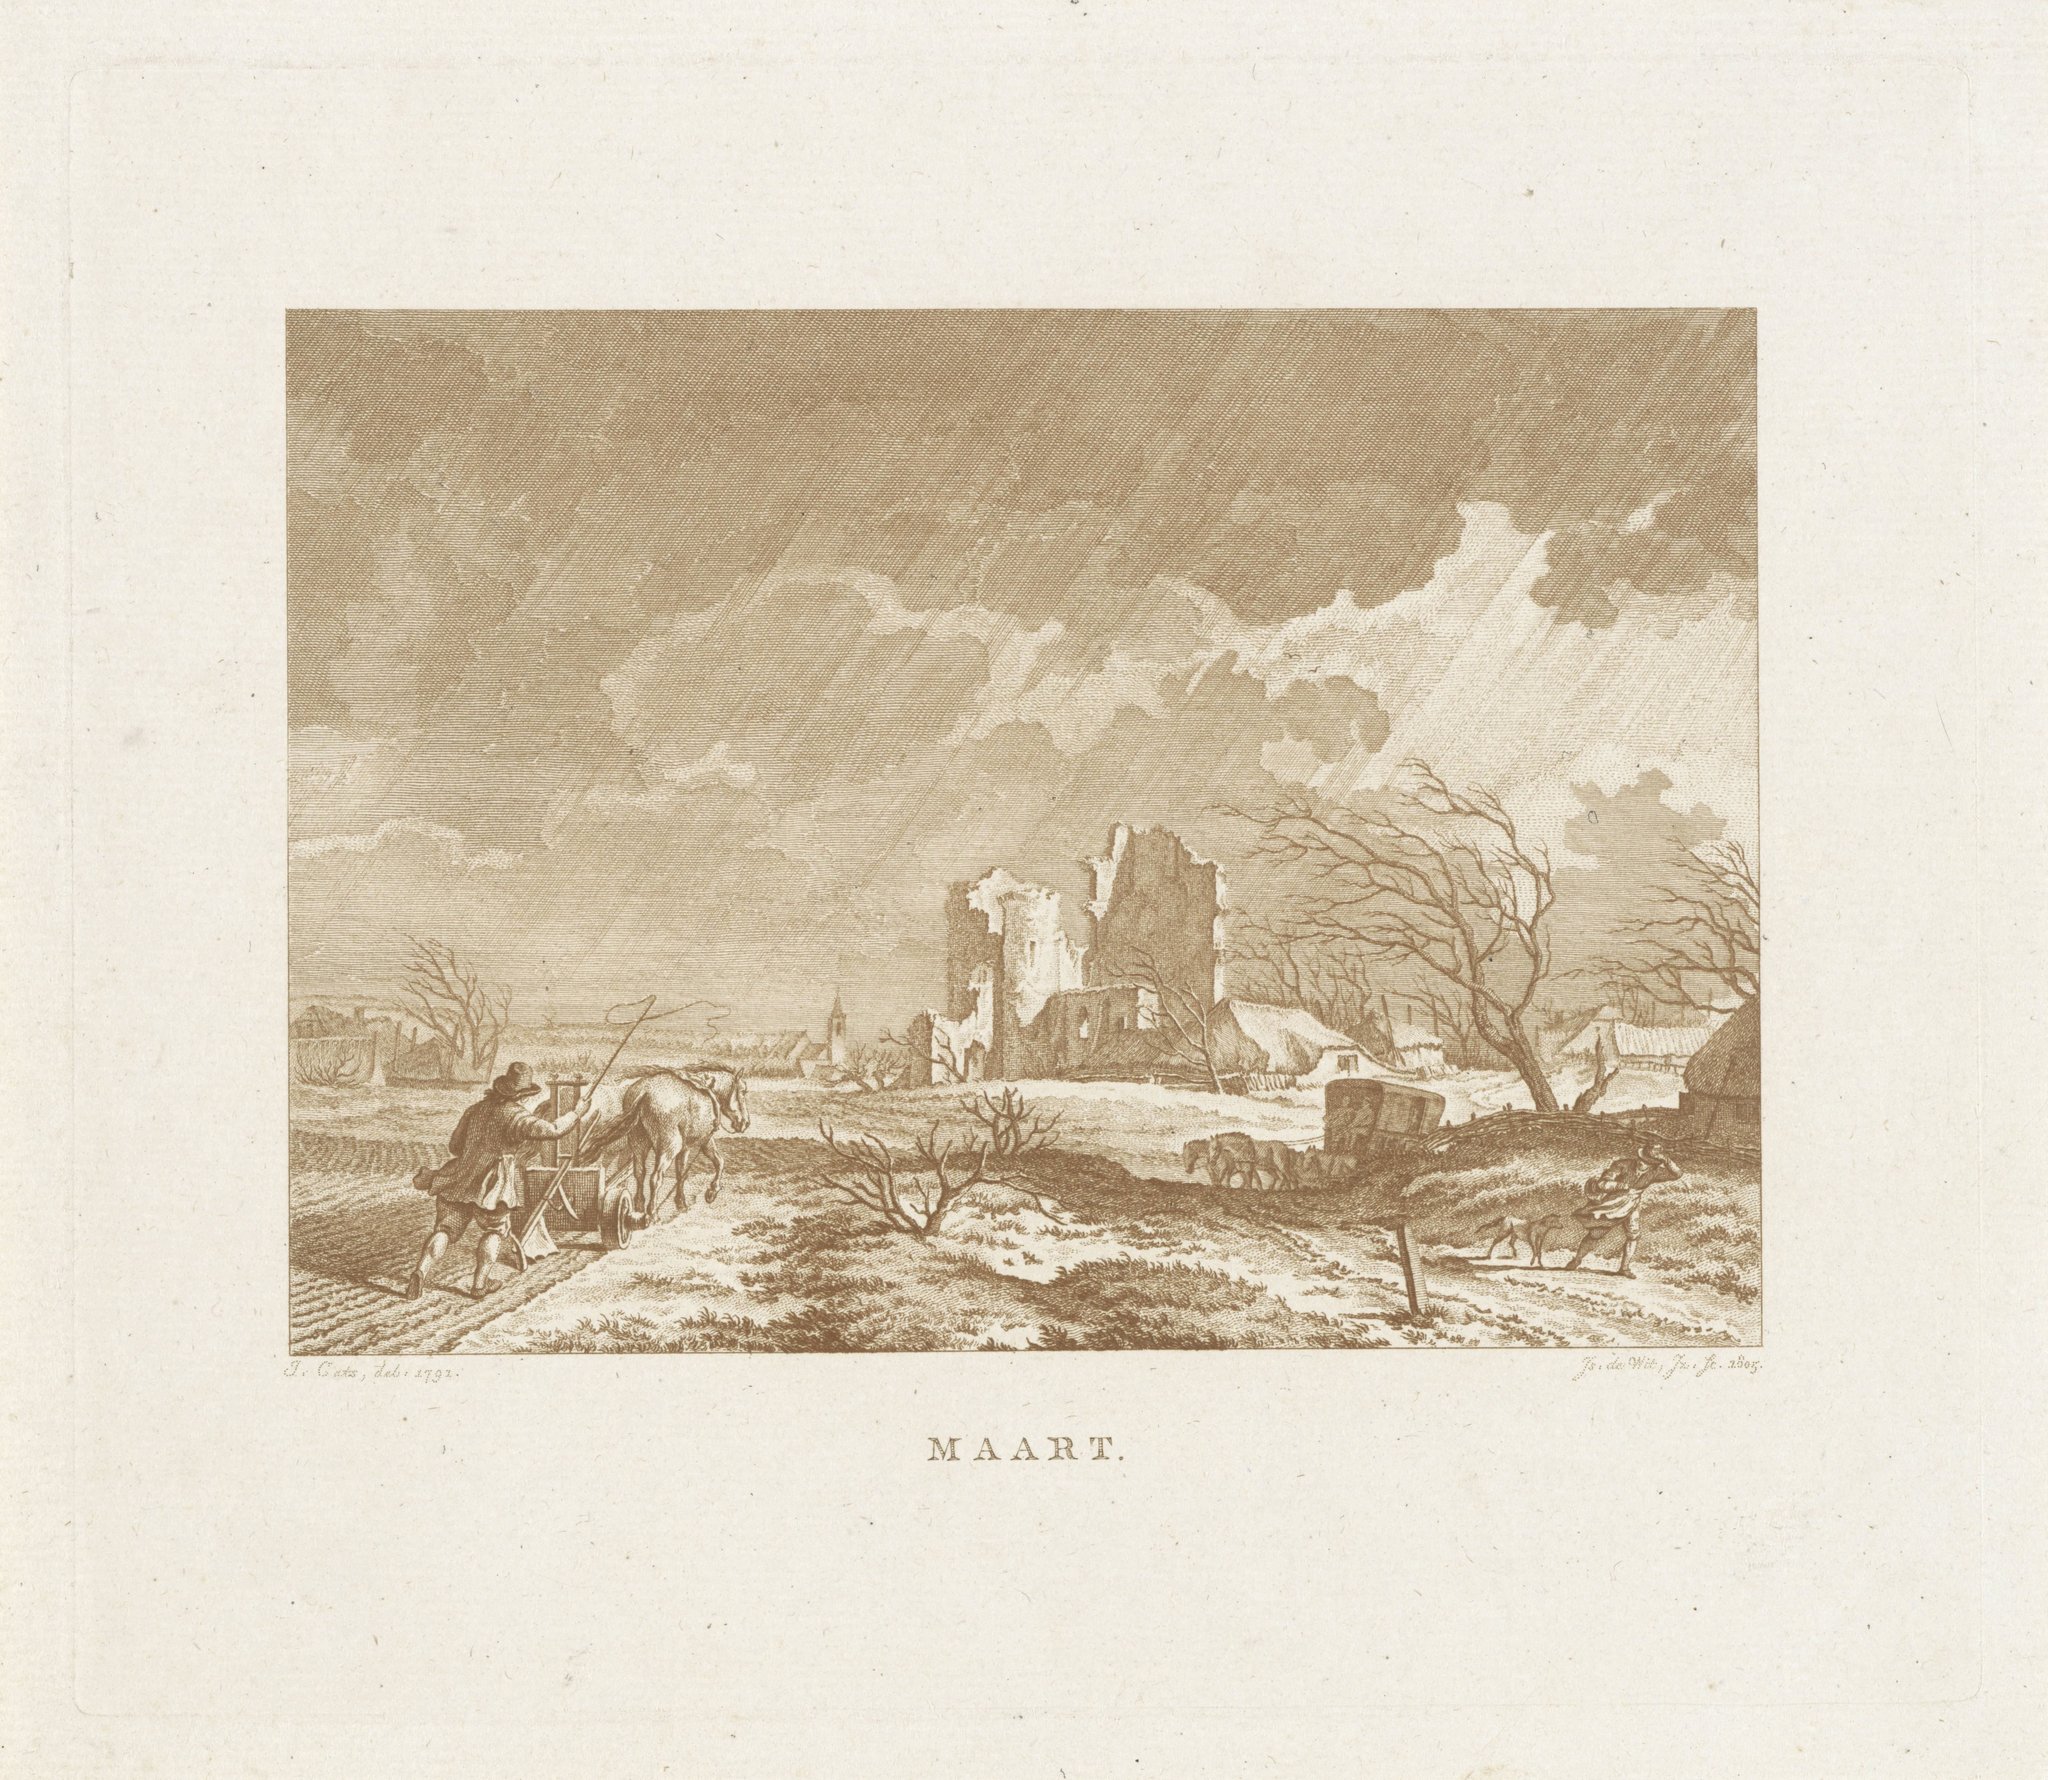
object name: print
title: Maart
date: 1805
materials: paper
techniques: etching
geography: haarlem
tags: downpour, rain shower, march and its 'labours' (+ with scenes showing human occupations ~ seasons and months), landscape with ruins, ploughing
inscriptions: collector's mark: Lugt 2228